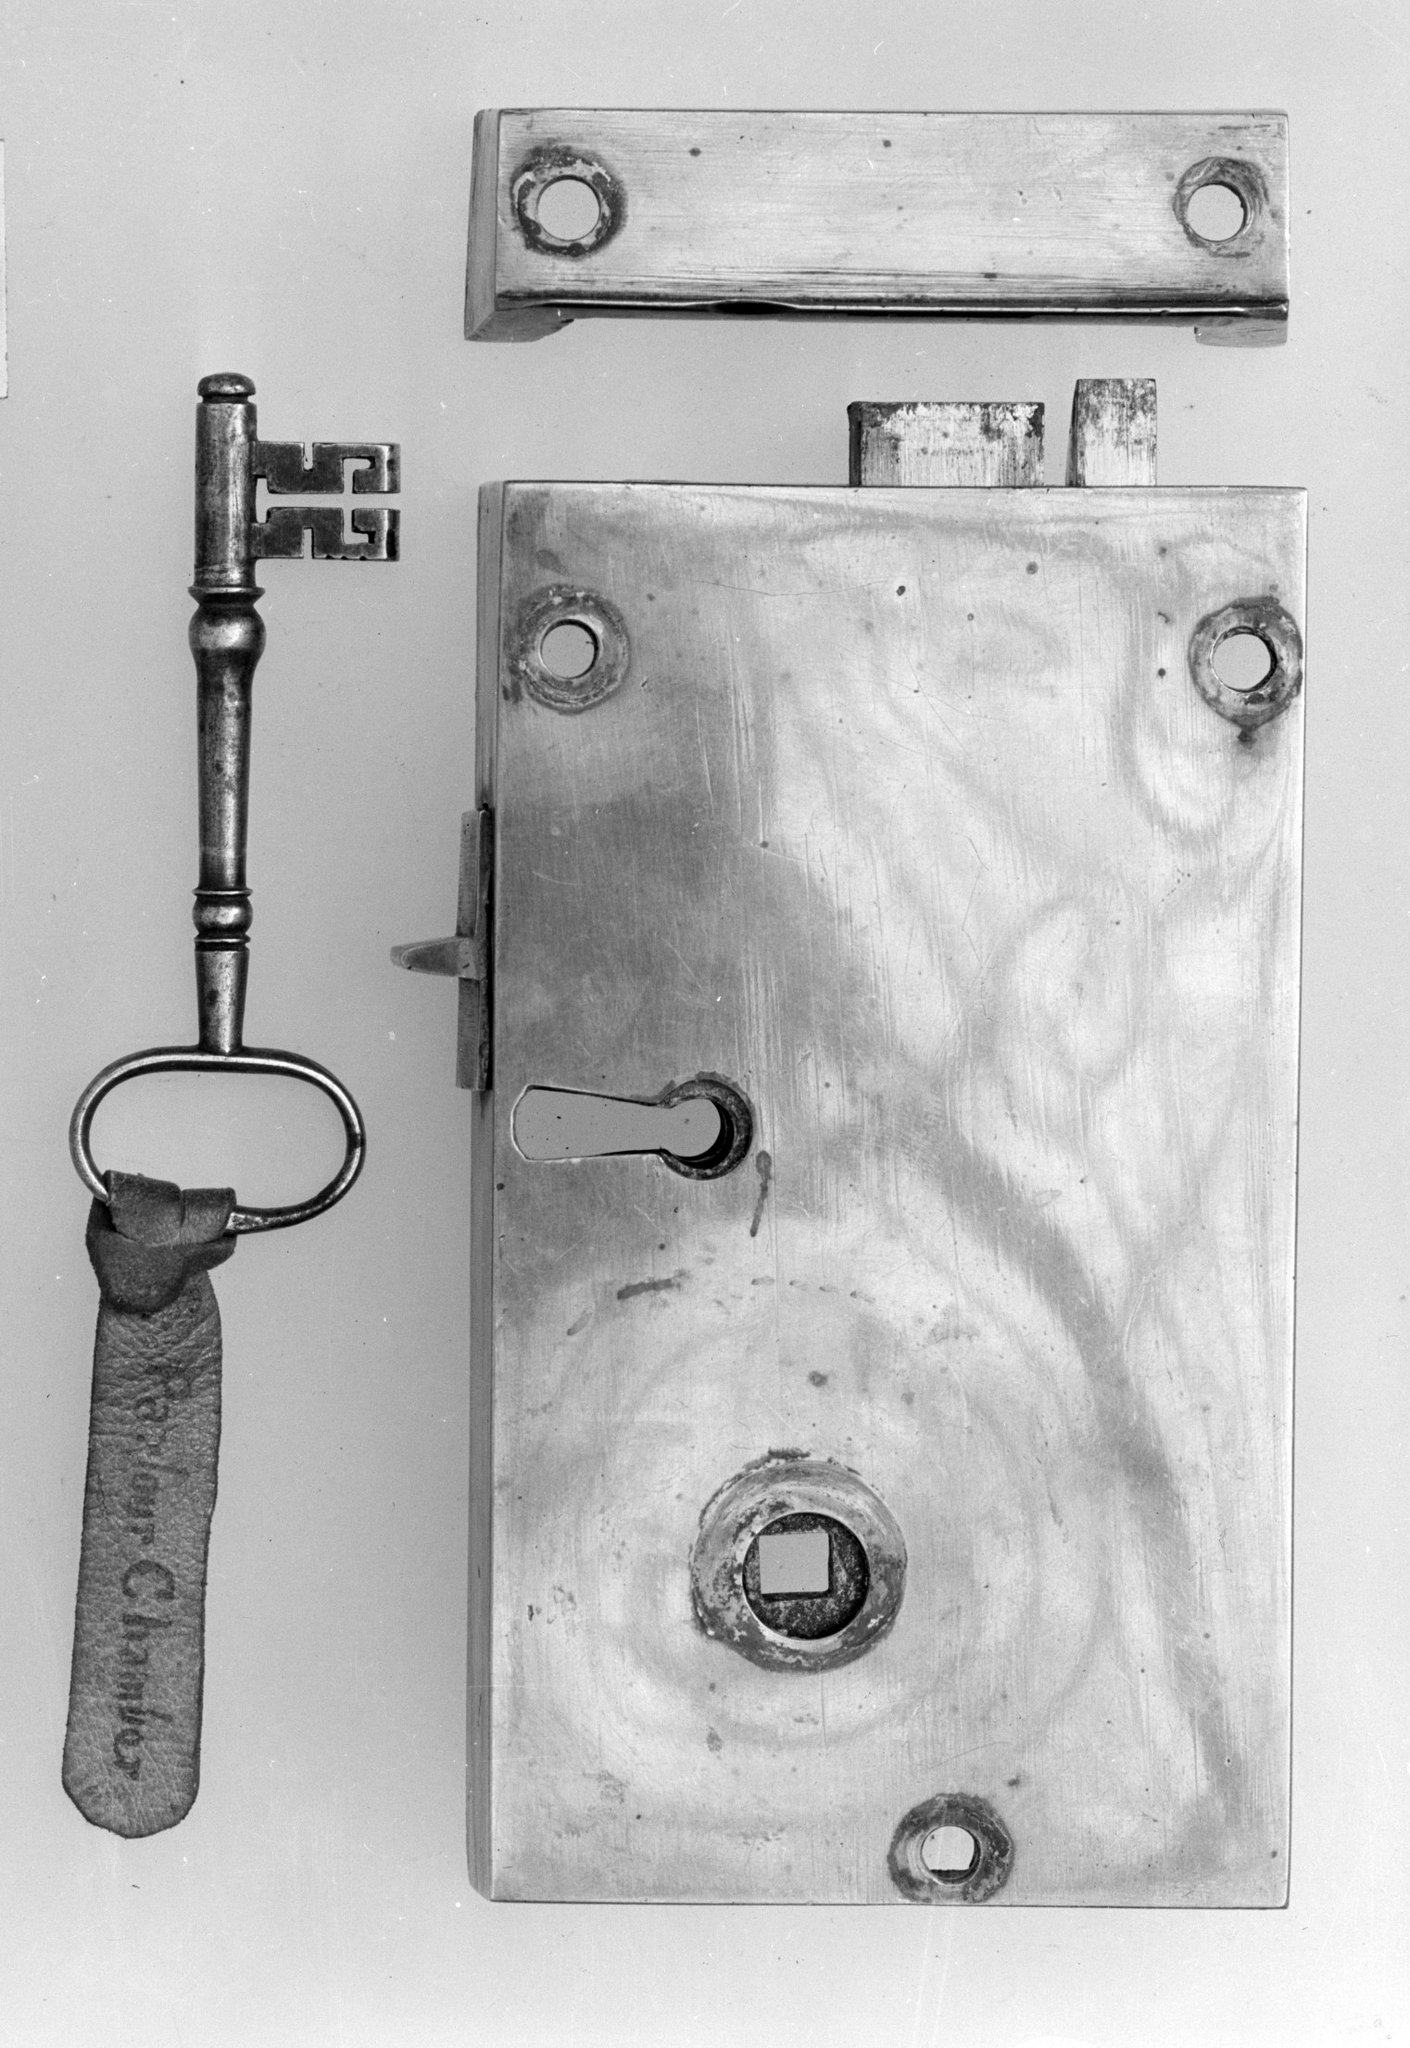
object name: lock and key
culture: american or british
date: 1700-1800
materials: brass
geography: england